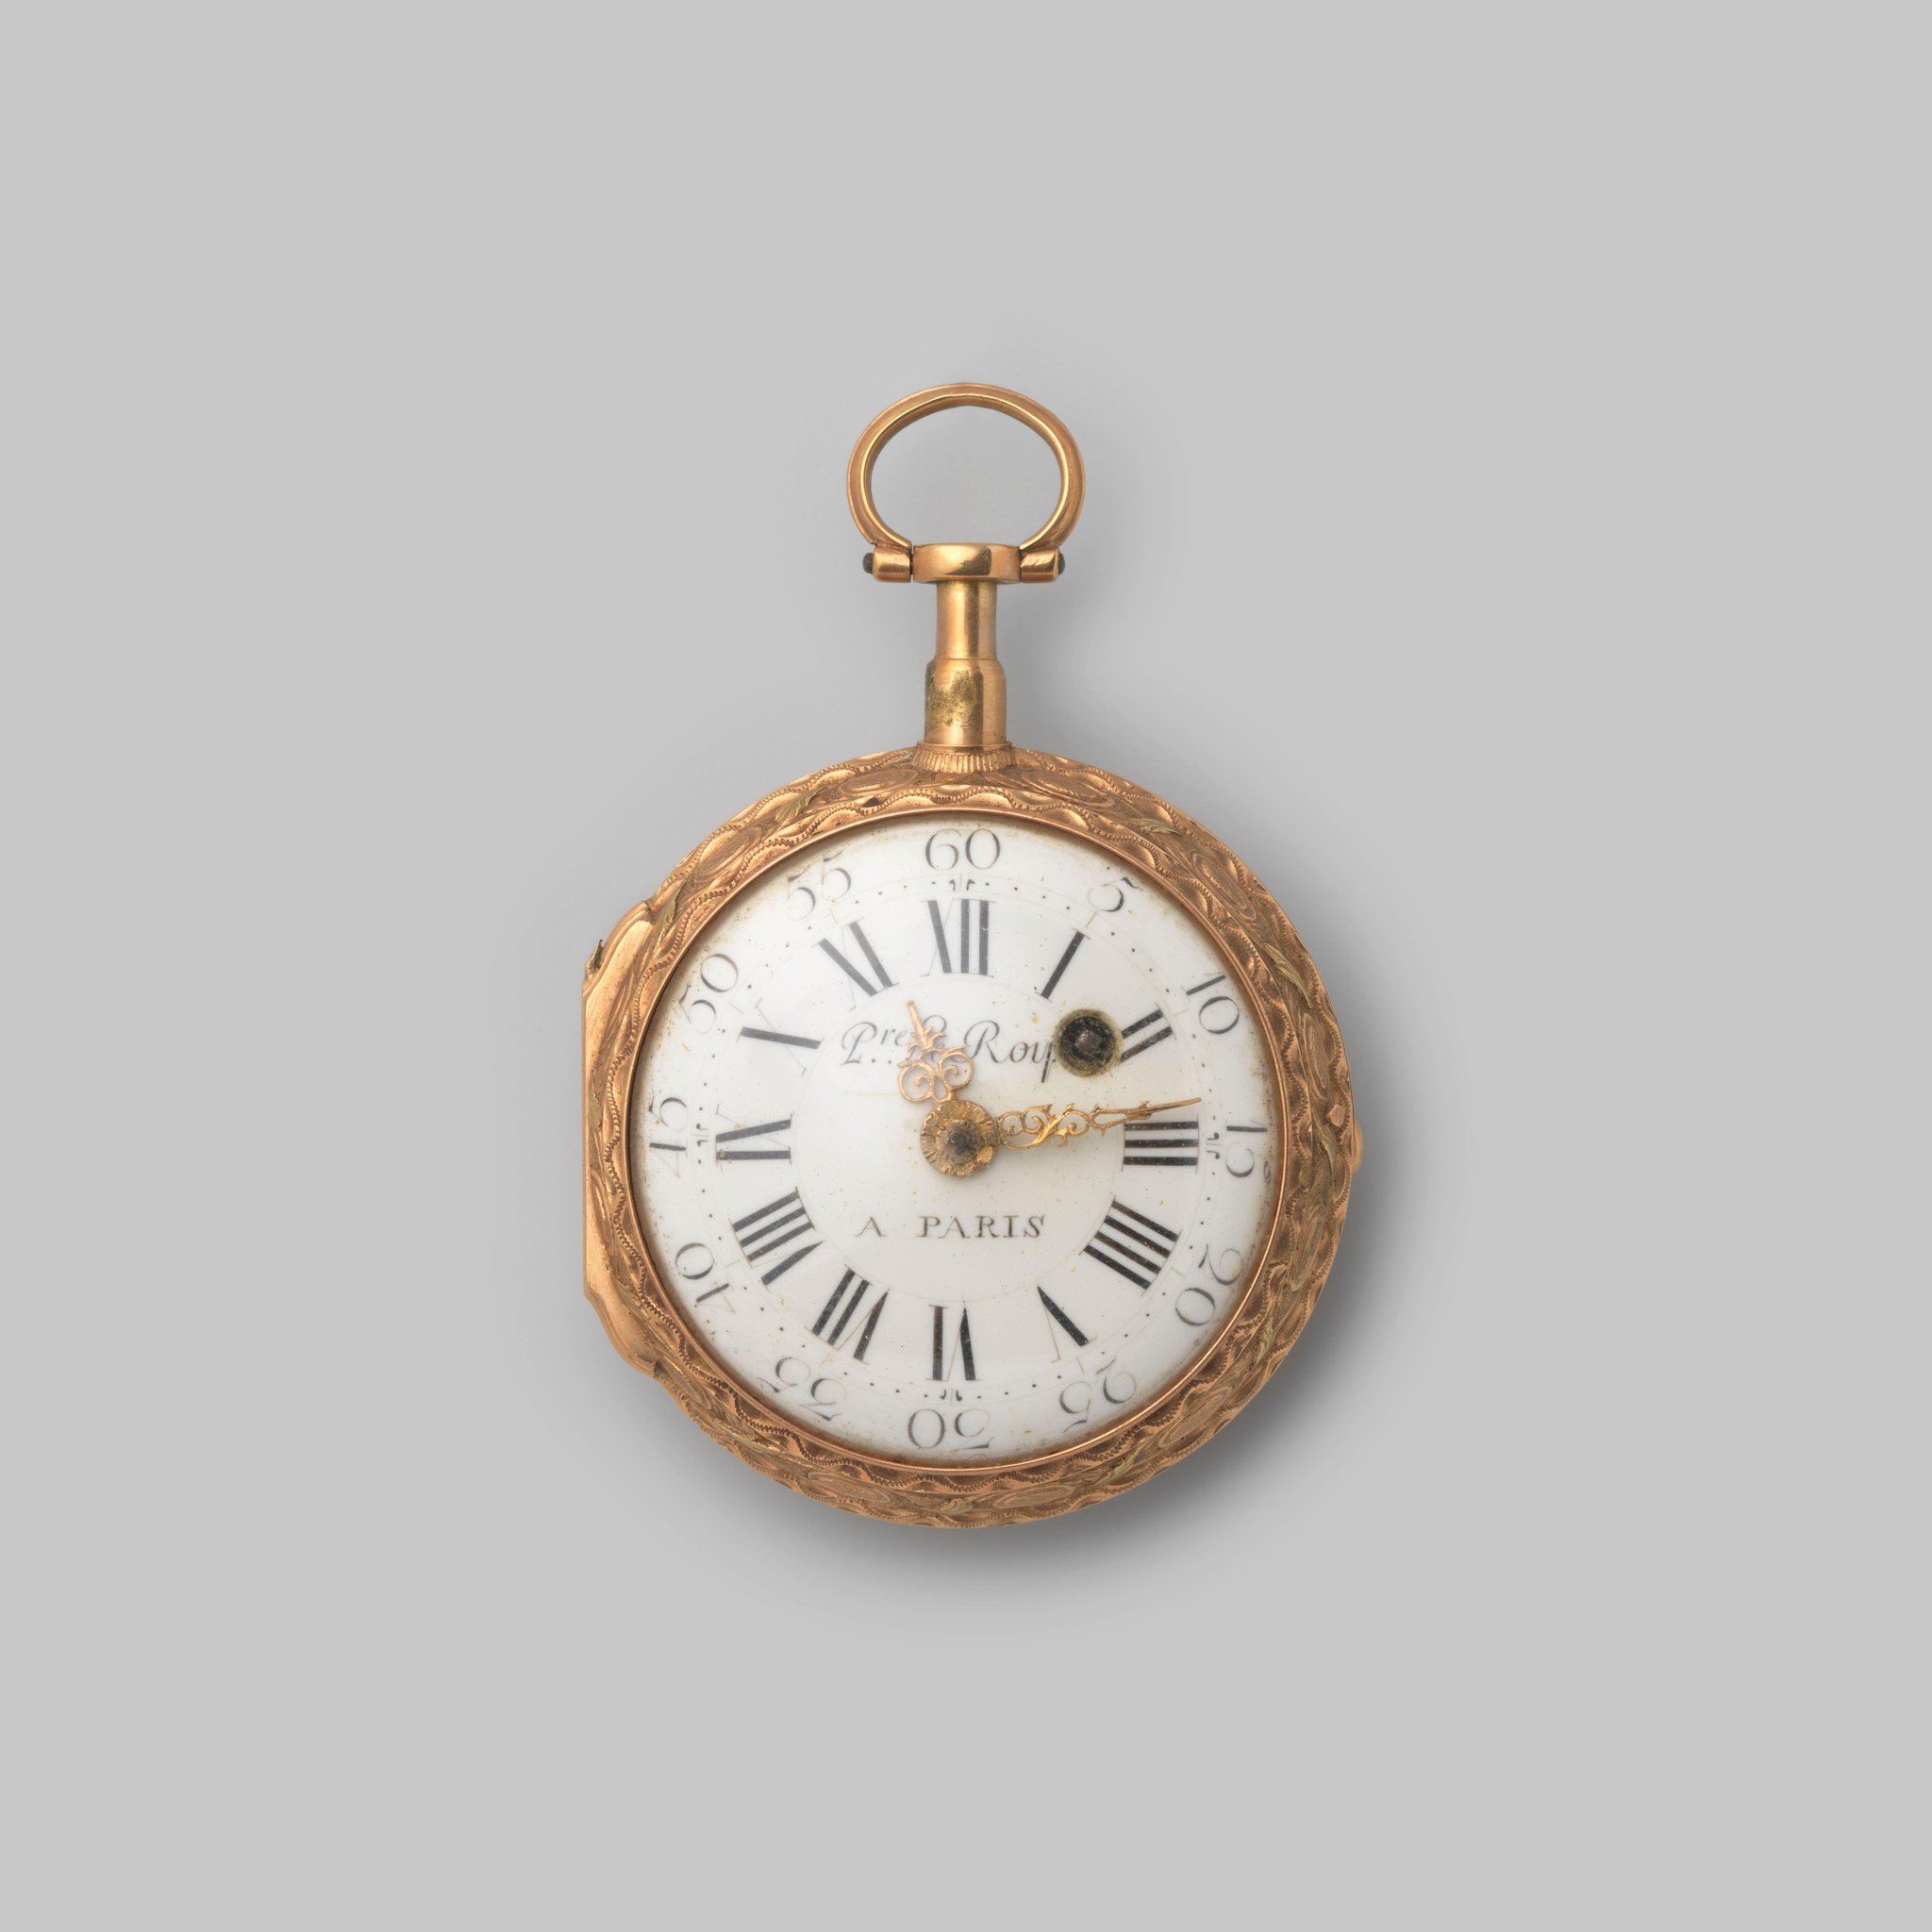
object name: jewellery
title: Horloge van goud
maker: le roy (uurwerkmaker)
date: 1800-1900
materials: gold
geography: paris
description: Gouden horloge met wit geëmailleerde wijzerplaat. Op de kast een geciseleerde versiering à quatre couleurs en een veelkleurig geëmailleerd medaillon met nymfem bij een bron.